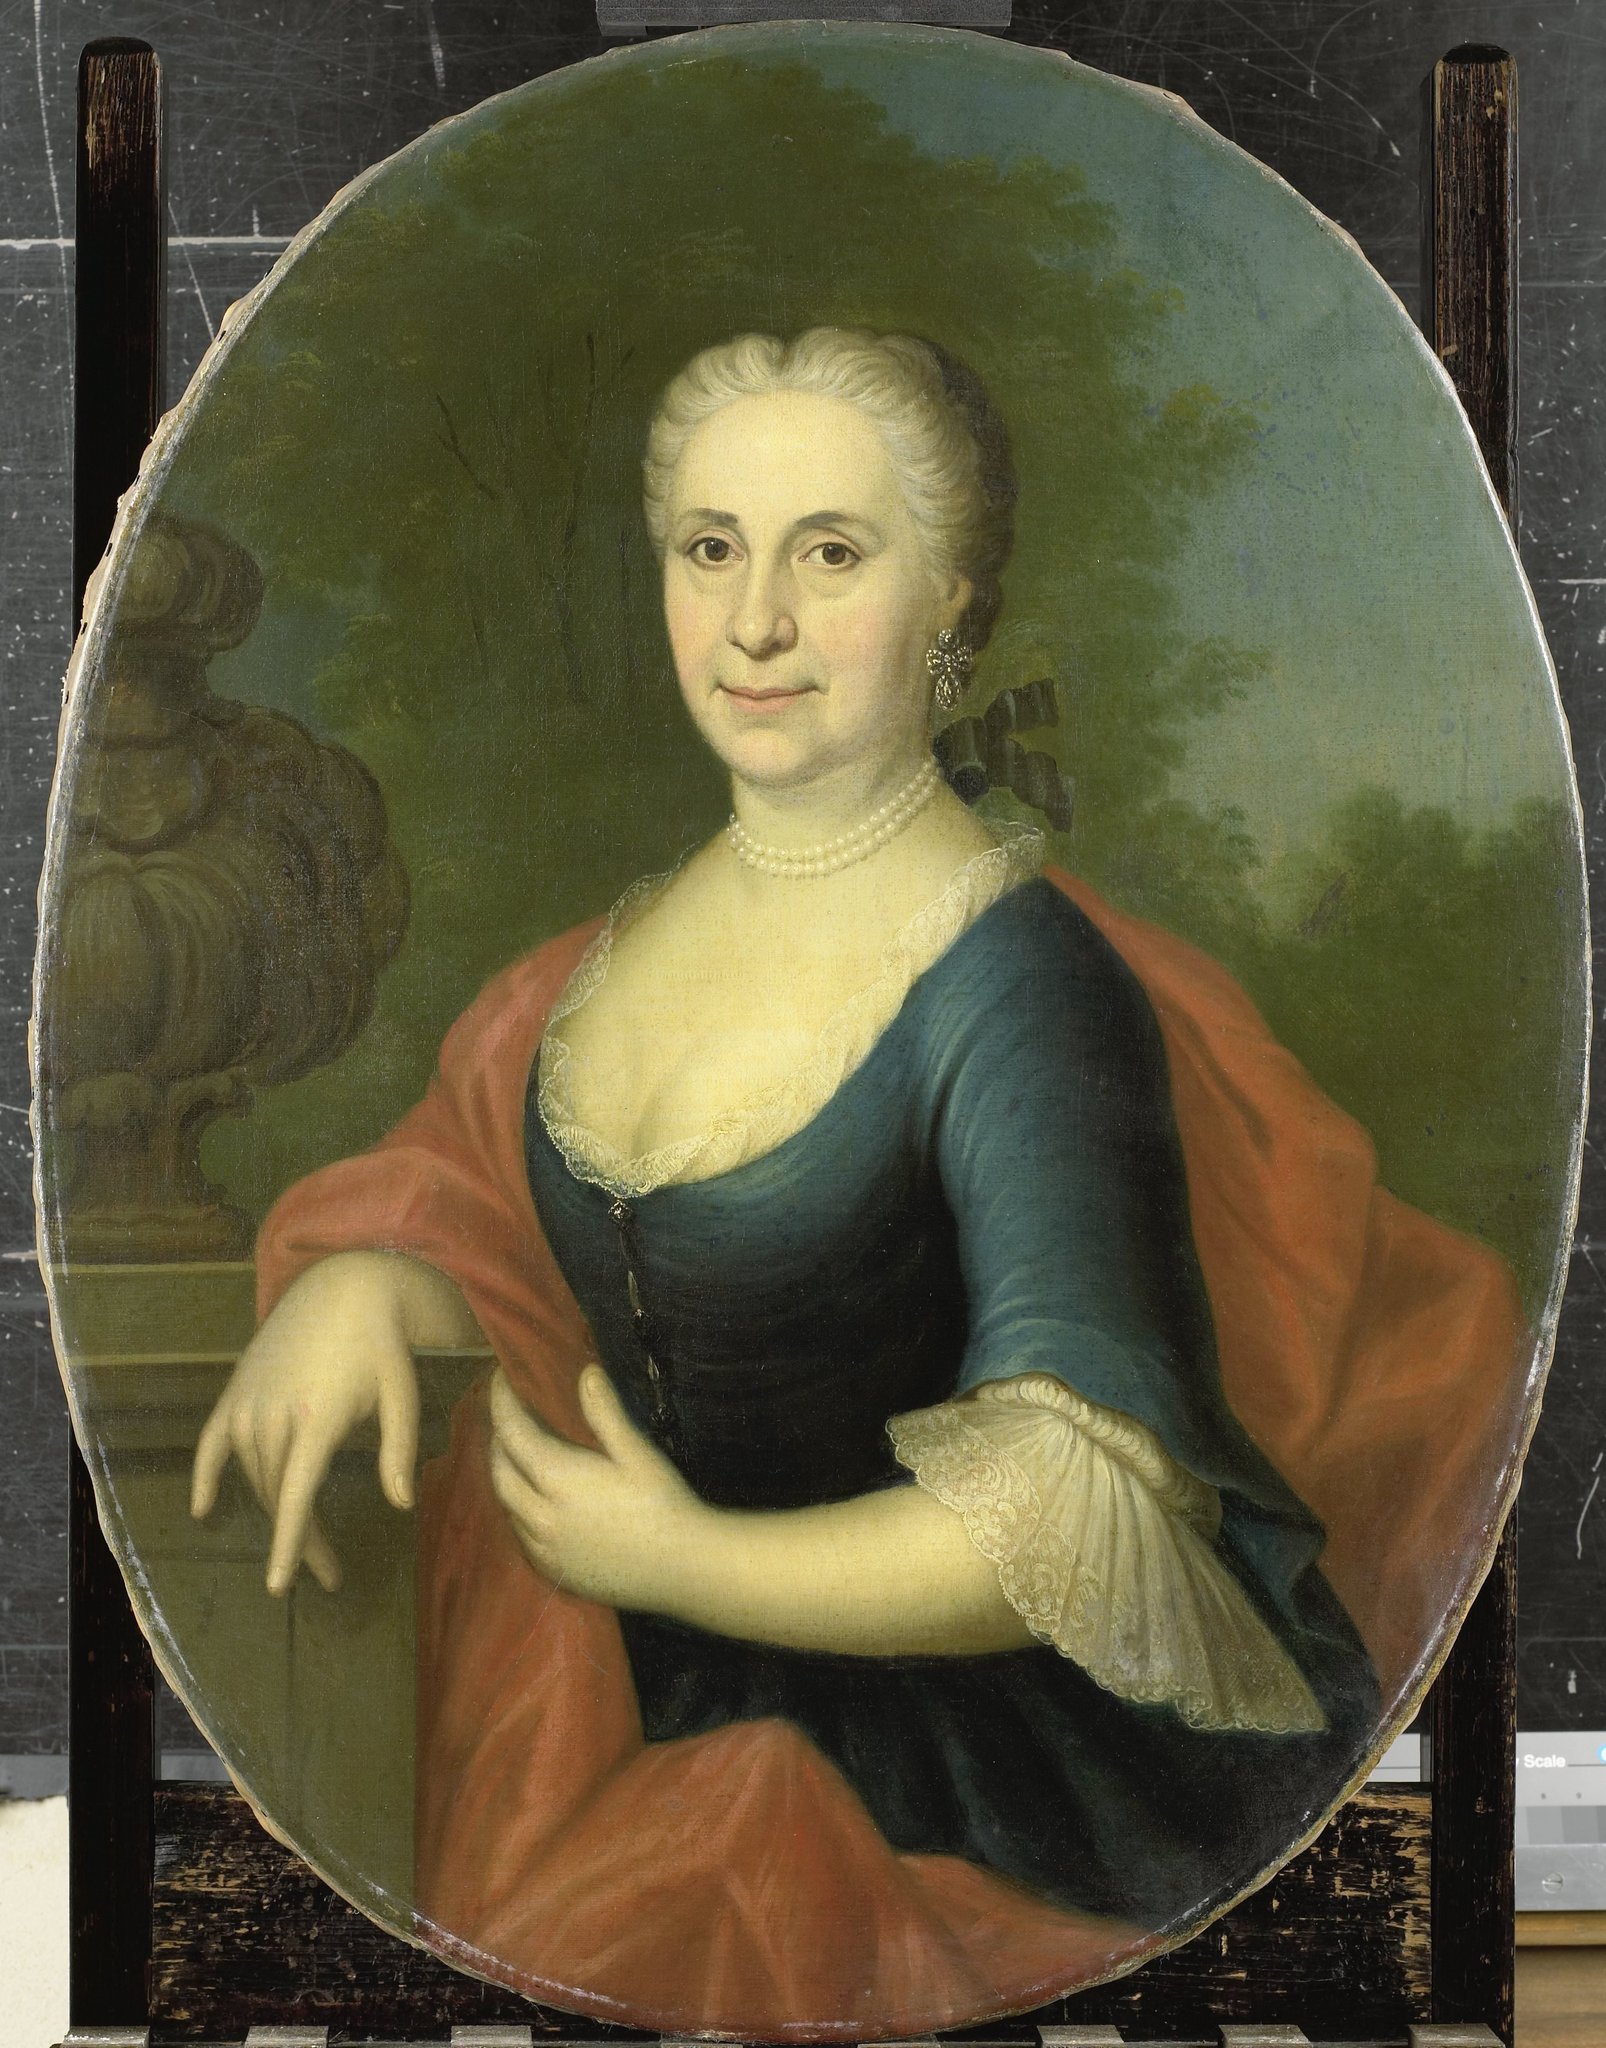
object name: painting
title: Cornelia van Schuylenburgh (1703-84), Wife of Diederik van Bleyswijk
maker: conrad kuster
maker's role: painter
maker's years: 1730-1802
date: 1761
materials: canvas, oil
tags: historical persons - bb - woman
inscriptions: signature and date: ‘K. Kuster. pinx. 1761.’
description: Portret van Cornelia van Schuylenburgh, sinds 1734 echtgenote van Diederik van Bleyswijk. Ovaal portret, staand, ten halven lijve bij een balustrade waarop een tuinvaas staat. Op de achtergrond geboomte. Pendant van SK-A-3859.